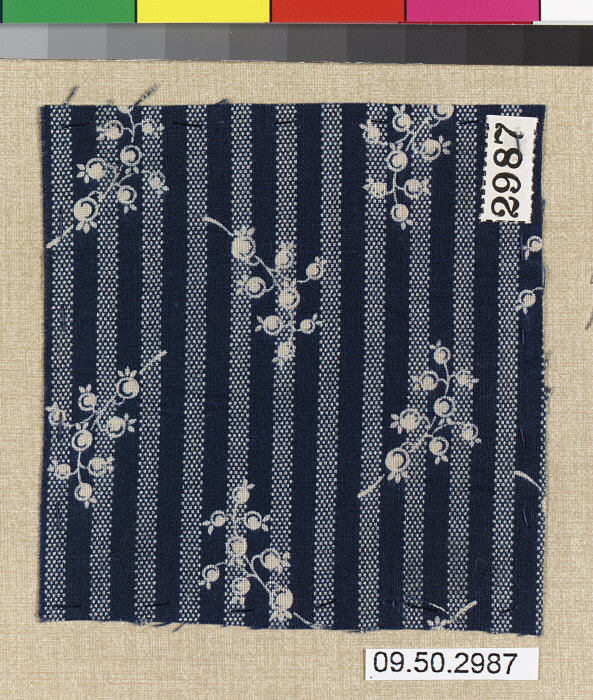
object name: piece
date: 1801-1900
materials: cotton